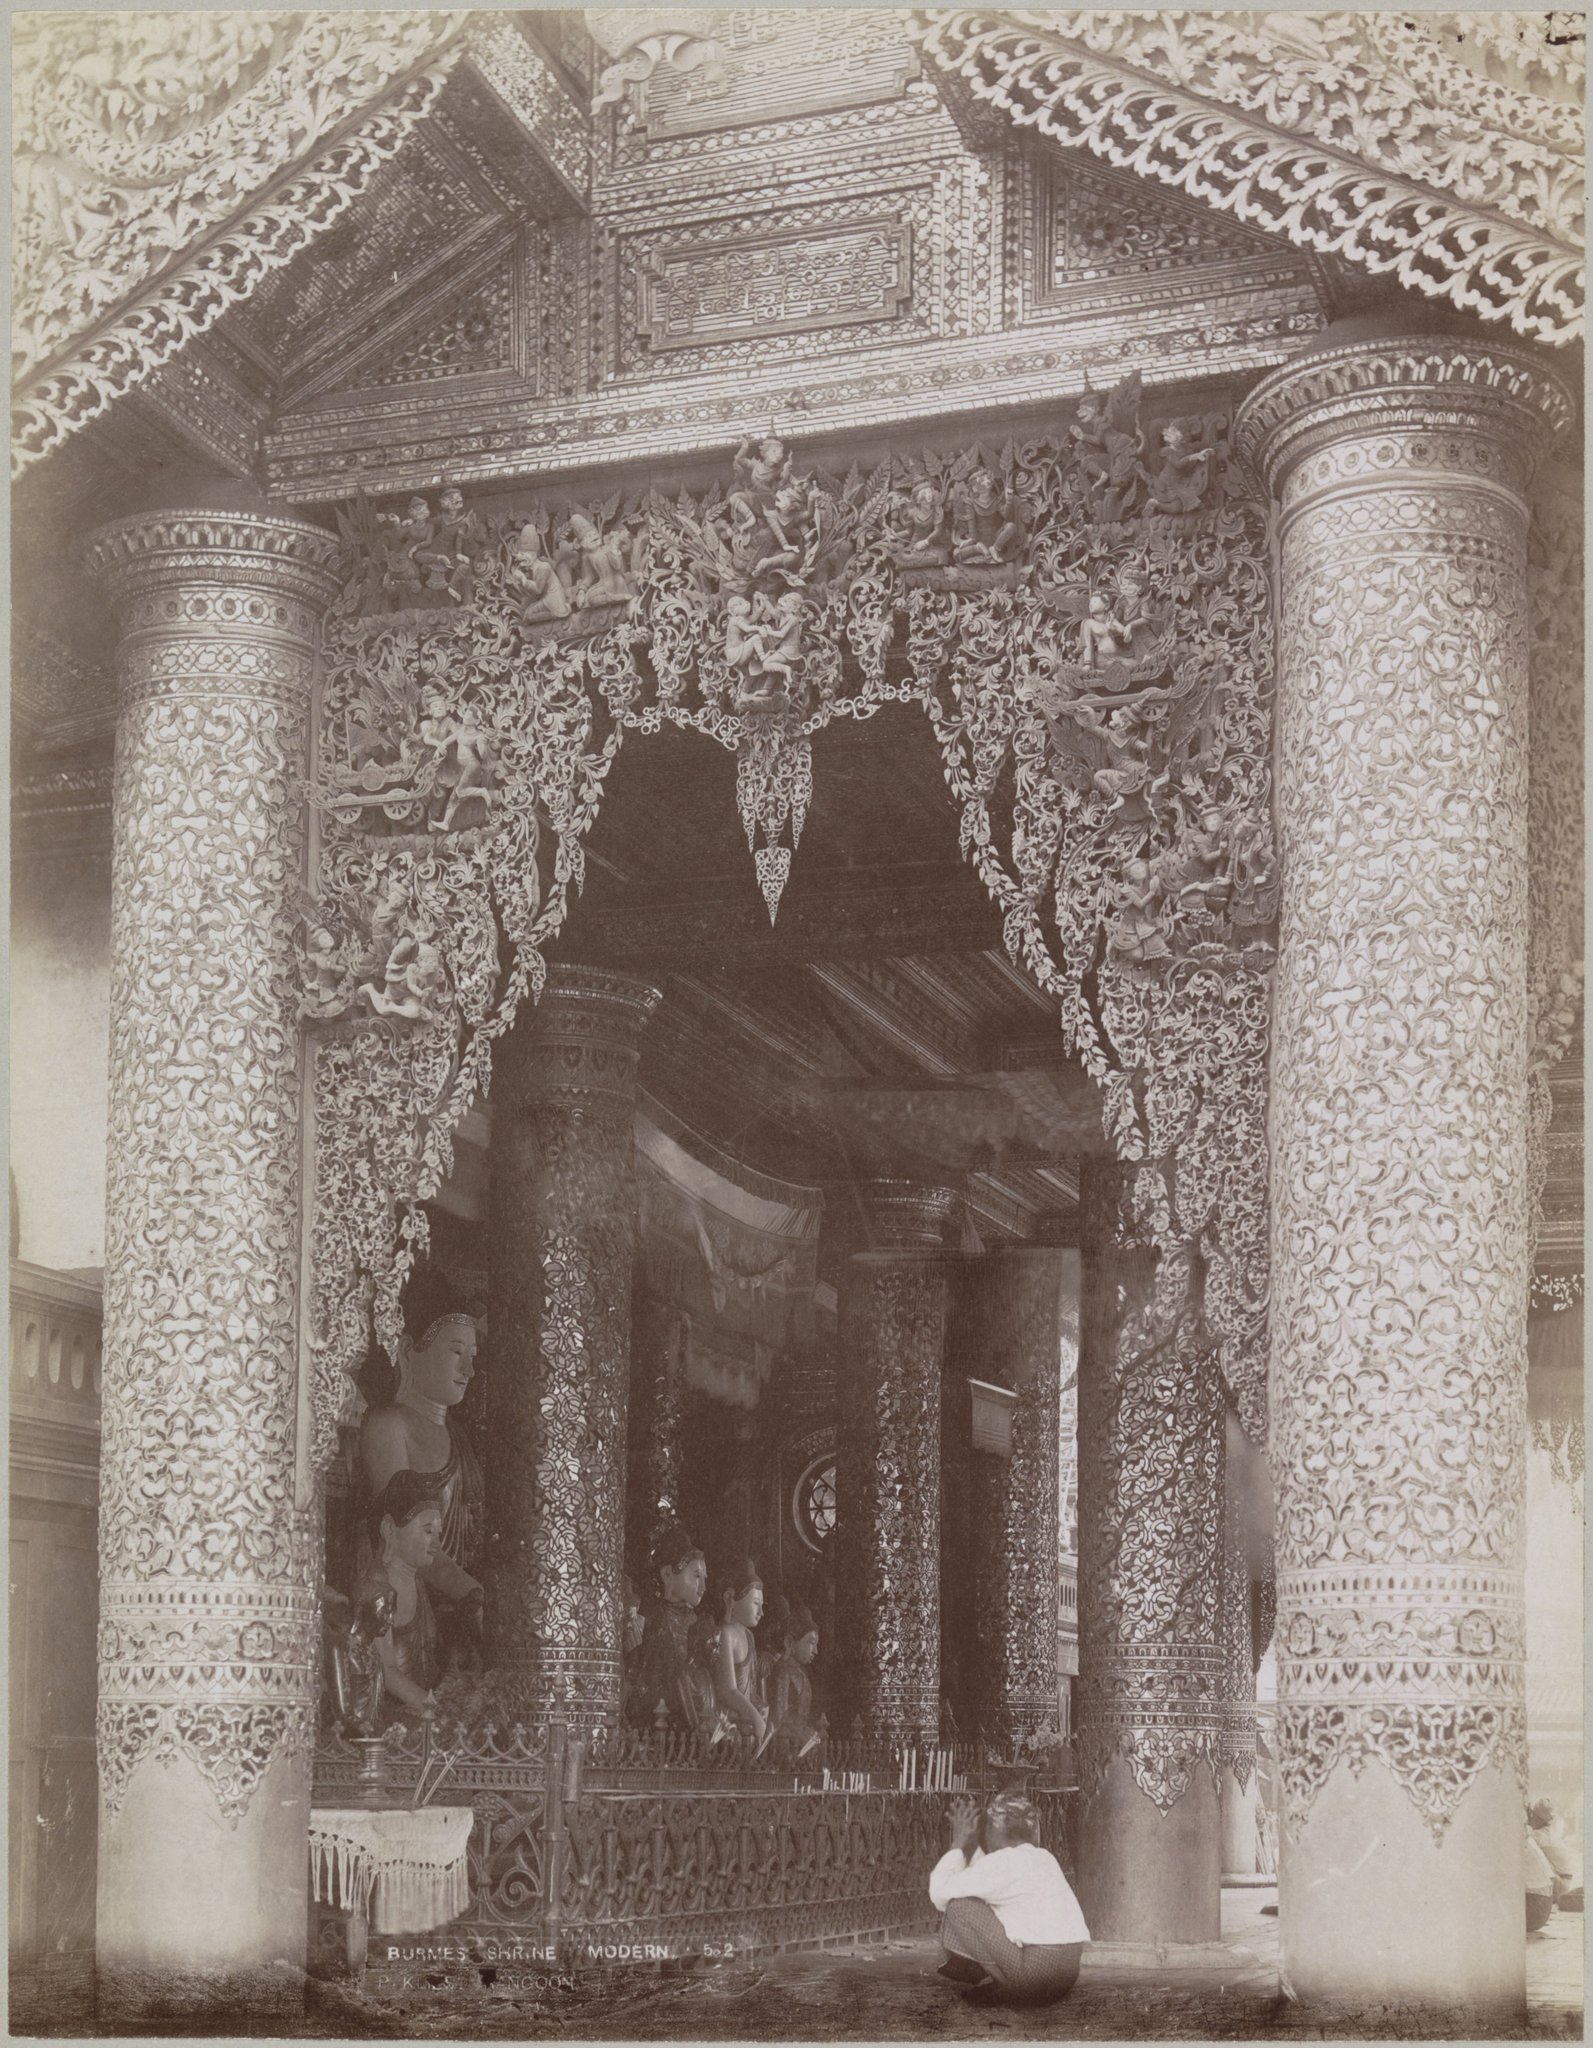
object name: photograph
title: Shrine in pagoda, Yangon, Myanmar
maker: philip adolphe klier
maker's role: fotograaf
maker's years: 1845-1911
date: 1895-1915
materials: cardboard, paper, photographic support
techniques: albumen print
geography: yangon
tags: birma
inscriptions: inscription: ‘Burmes Shrine Modern 502/ P. Klier Rangoon’, number: ‘4.’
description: In het midden zit een persoon te bidden.